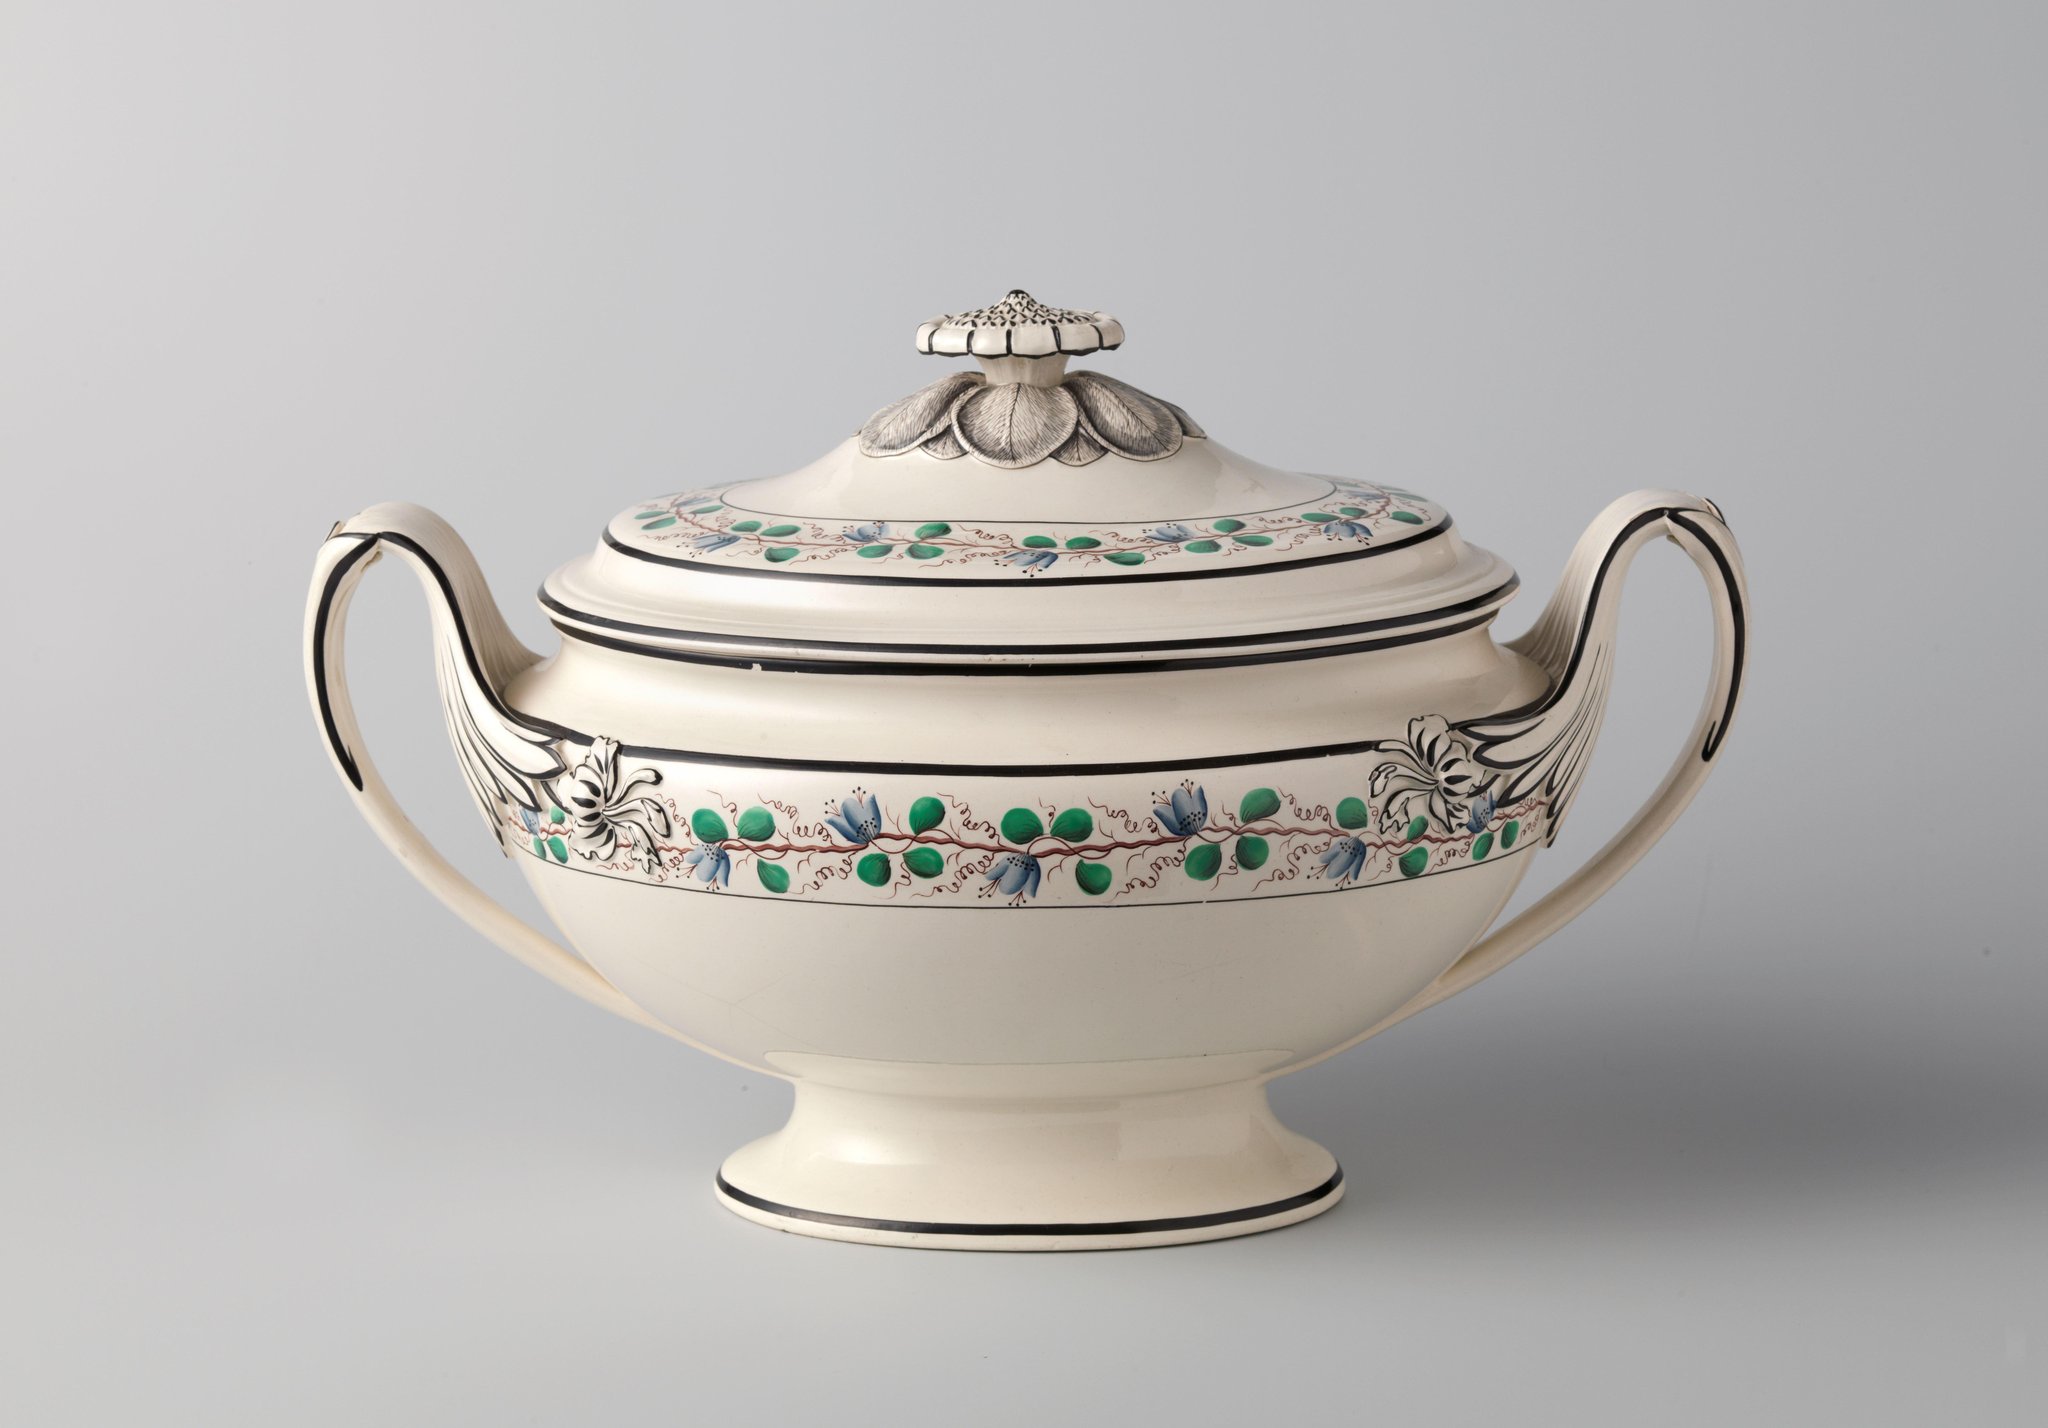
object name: lid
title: Deksel van hardgebakken aardewerk, Wedgood creamware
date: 1770-1780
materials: earthenware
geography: england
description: Deksel van hardgebakken aardewerk. Het deksel is gewelfd en heeft een platte knop in de vorm van een bloem. Het deksel is beschilderd met zwarte lijnen en een rank met bloemen en vruchten.